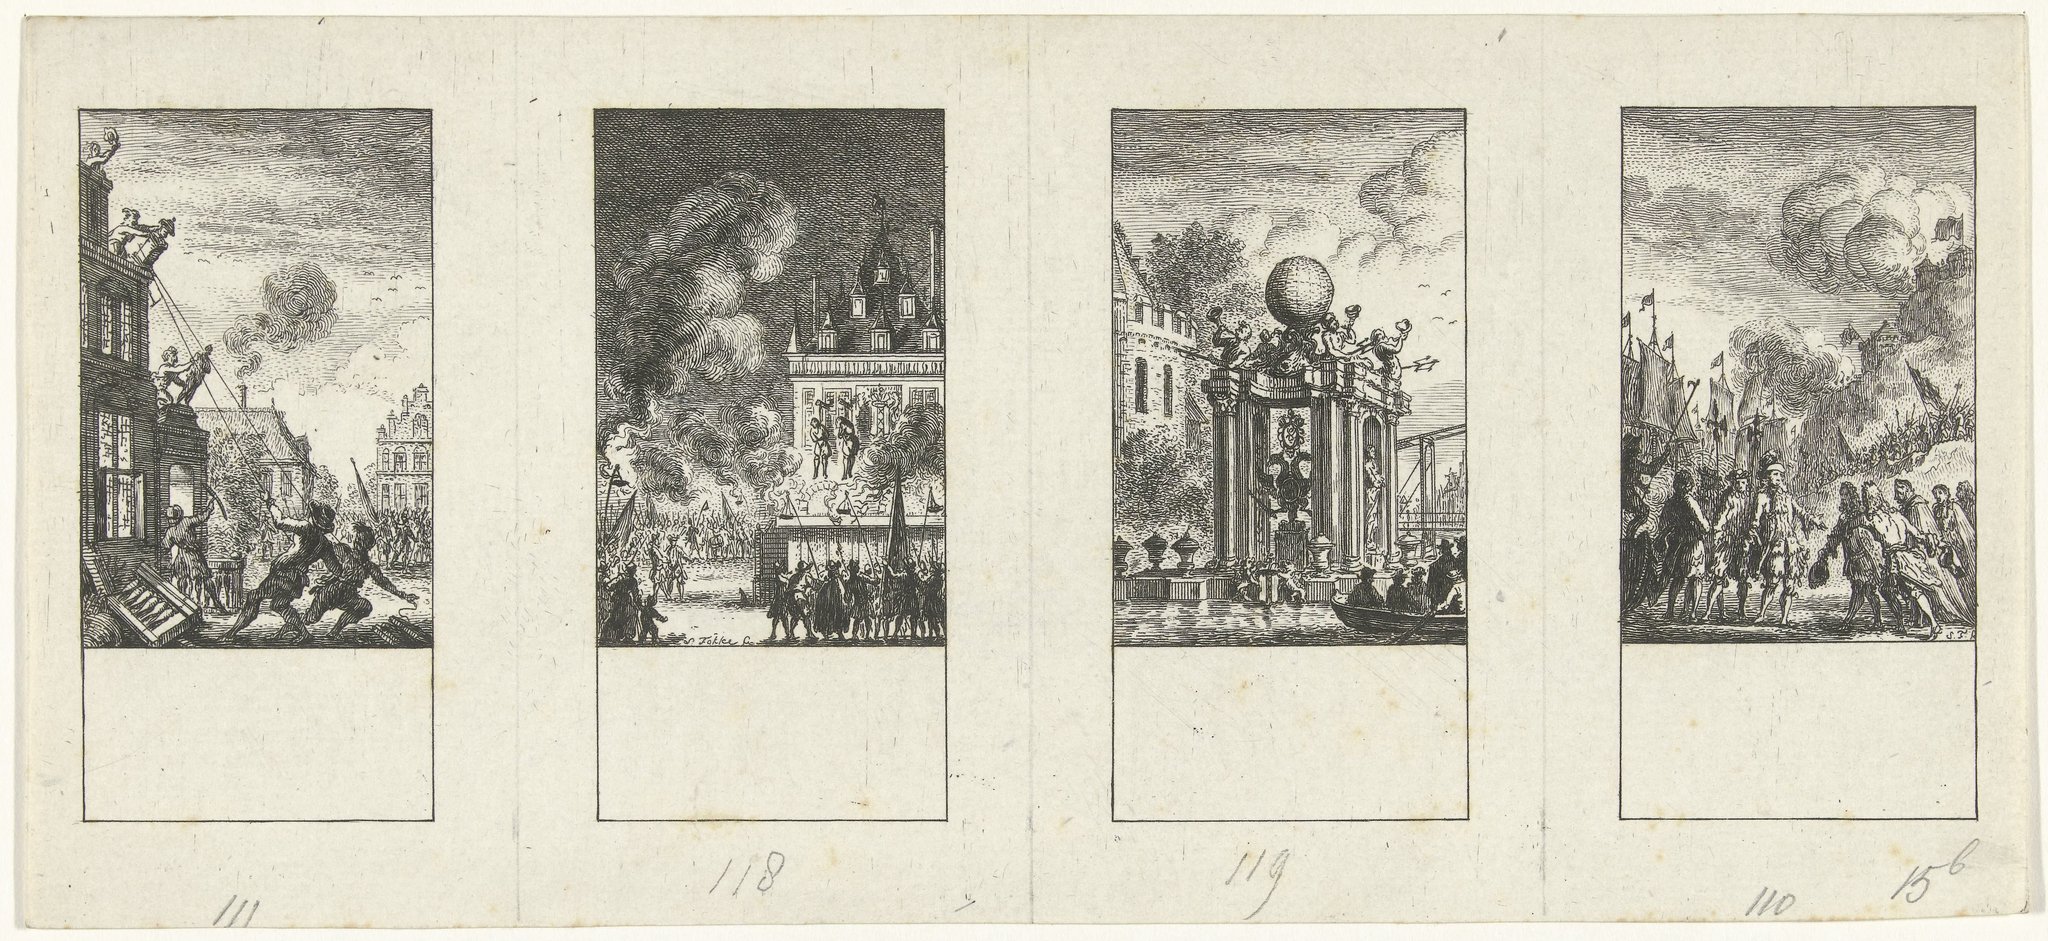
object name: print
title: Vier episodes uit de vaderlandse geschiedenis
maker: simon fokke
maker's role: draughtsman, print maker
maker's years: 1712-1784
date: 1722-1784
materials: paper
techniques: etching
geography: amsterdam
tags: the hague, william iii (prince of orange and king of england, scotland, and ireland), peter i de grote (tsaar van rusland), historical events and situations, historical persons (portraits and scenes from the life)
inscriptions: number: ‘111, 118, 119, 110’, collector's mark: Lugt 2228